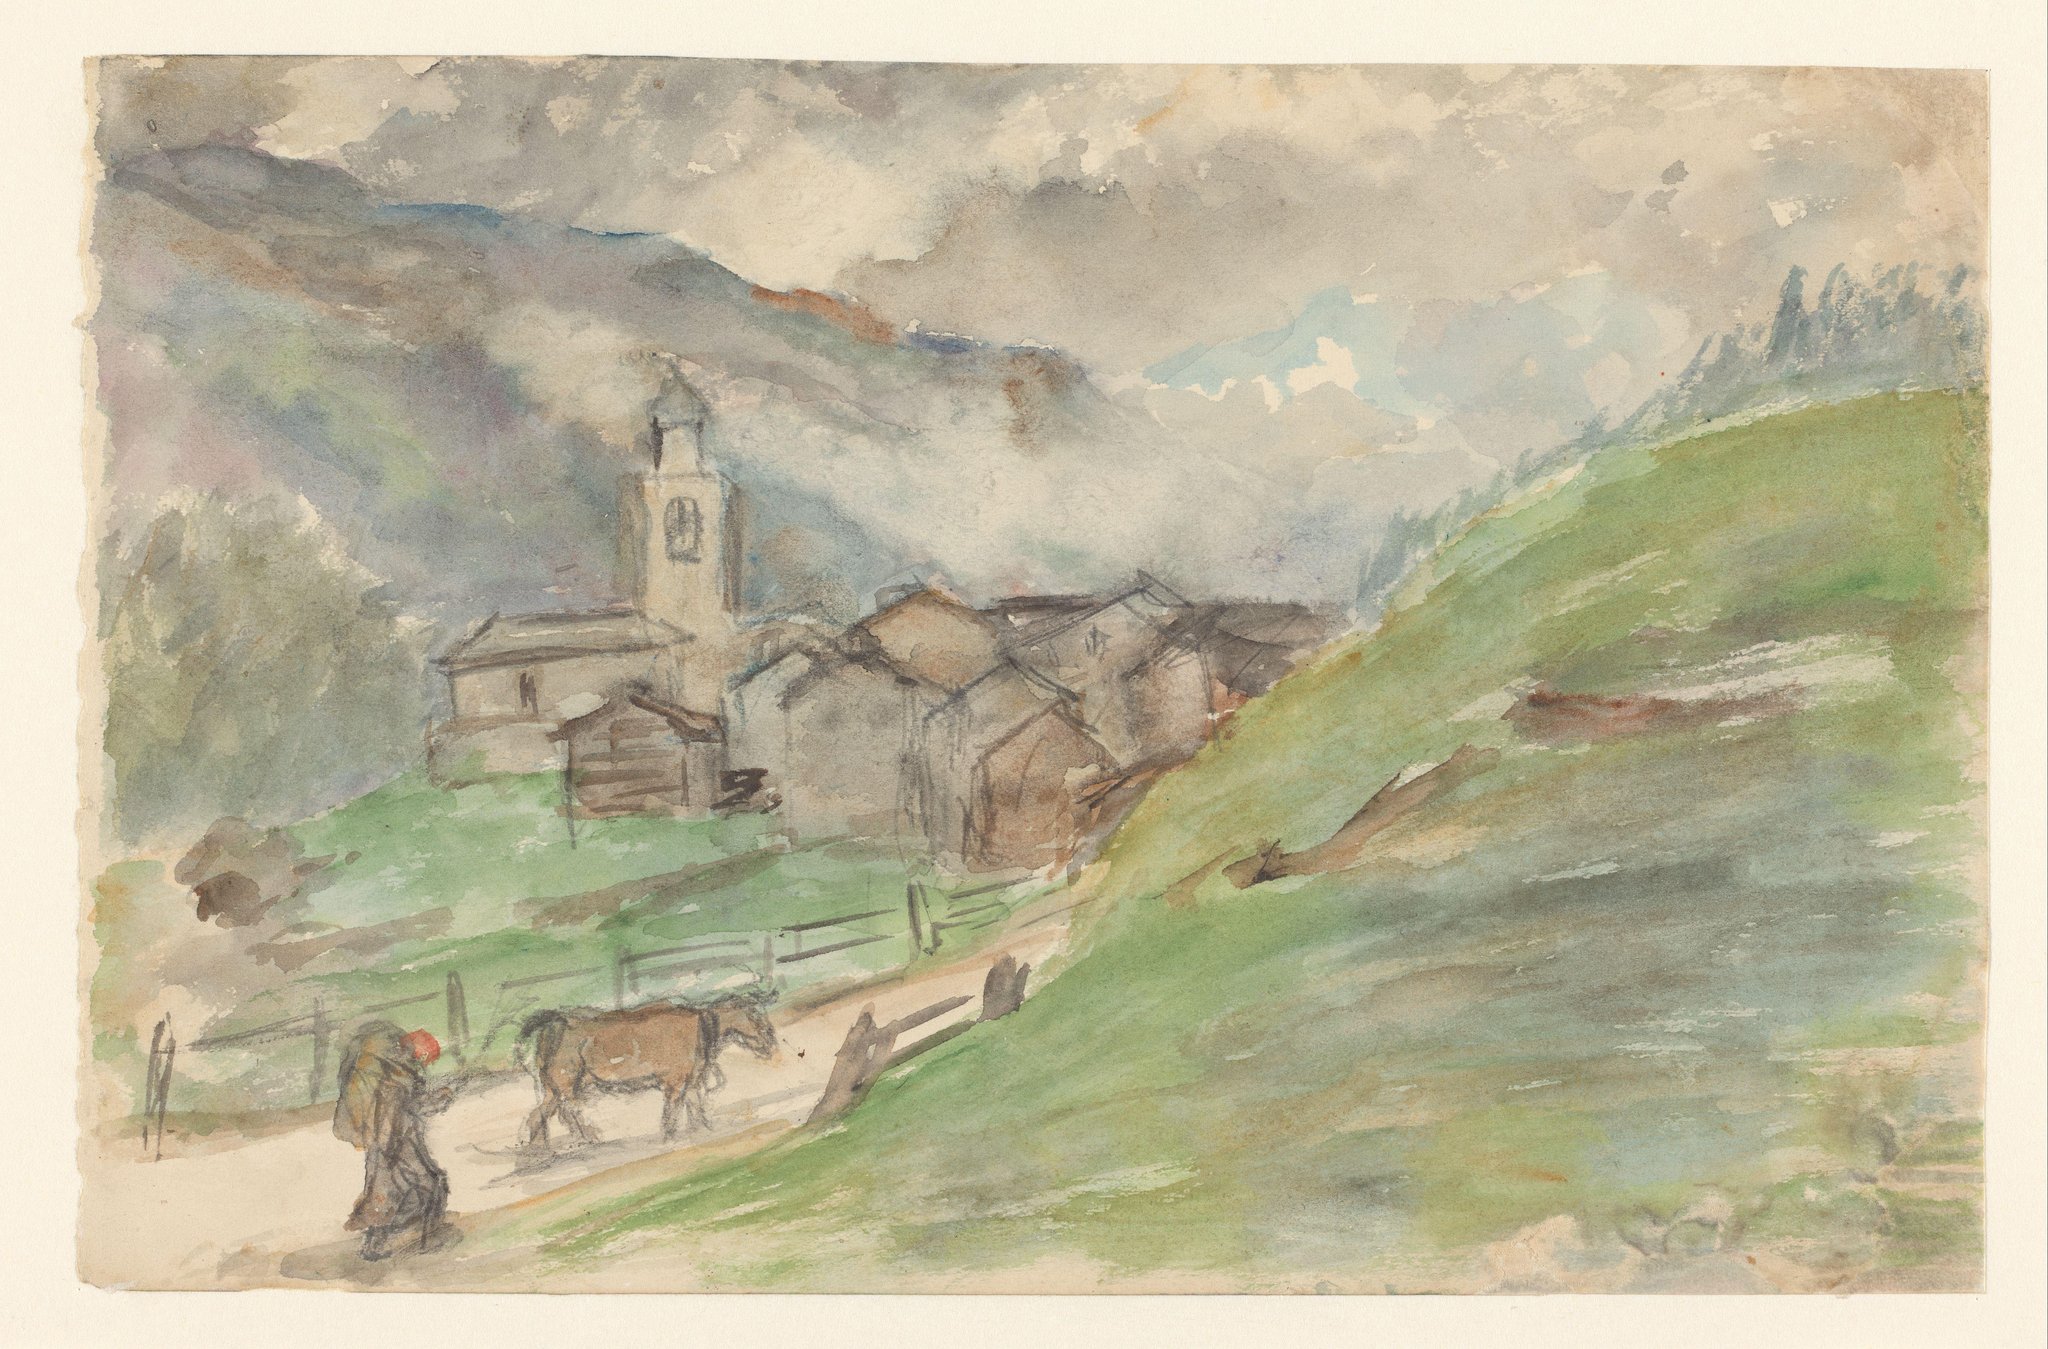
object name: watercolor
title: Bergdorpje met kerk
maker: jozef israëls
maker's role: draughtsman, painter, print maker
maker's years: 1824-1911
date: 1834-1911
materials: paper, pencil, watercolor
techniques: brush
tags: prospect of village, silhouette of village, mountains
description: Bergdorpje met kerk, vooraan een oude vrouw met koe.